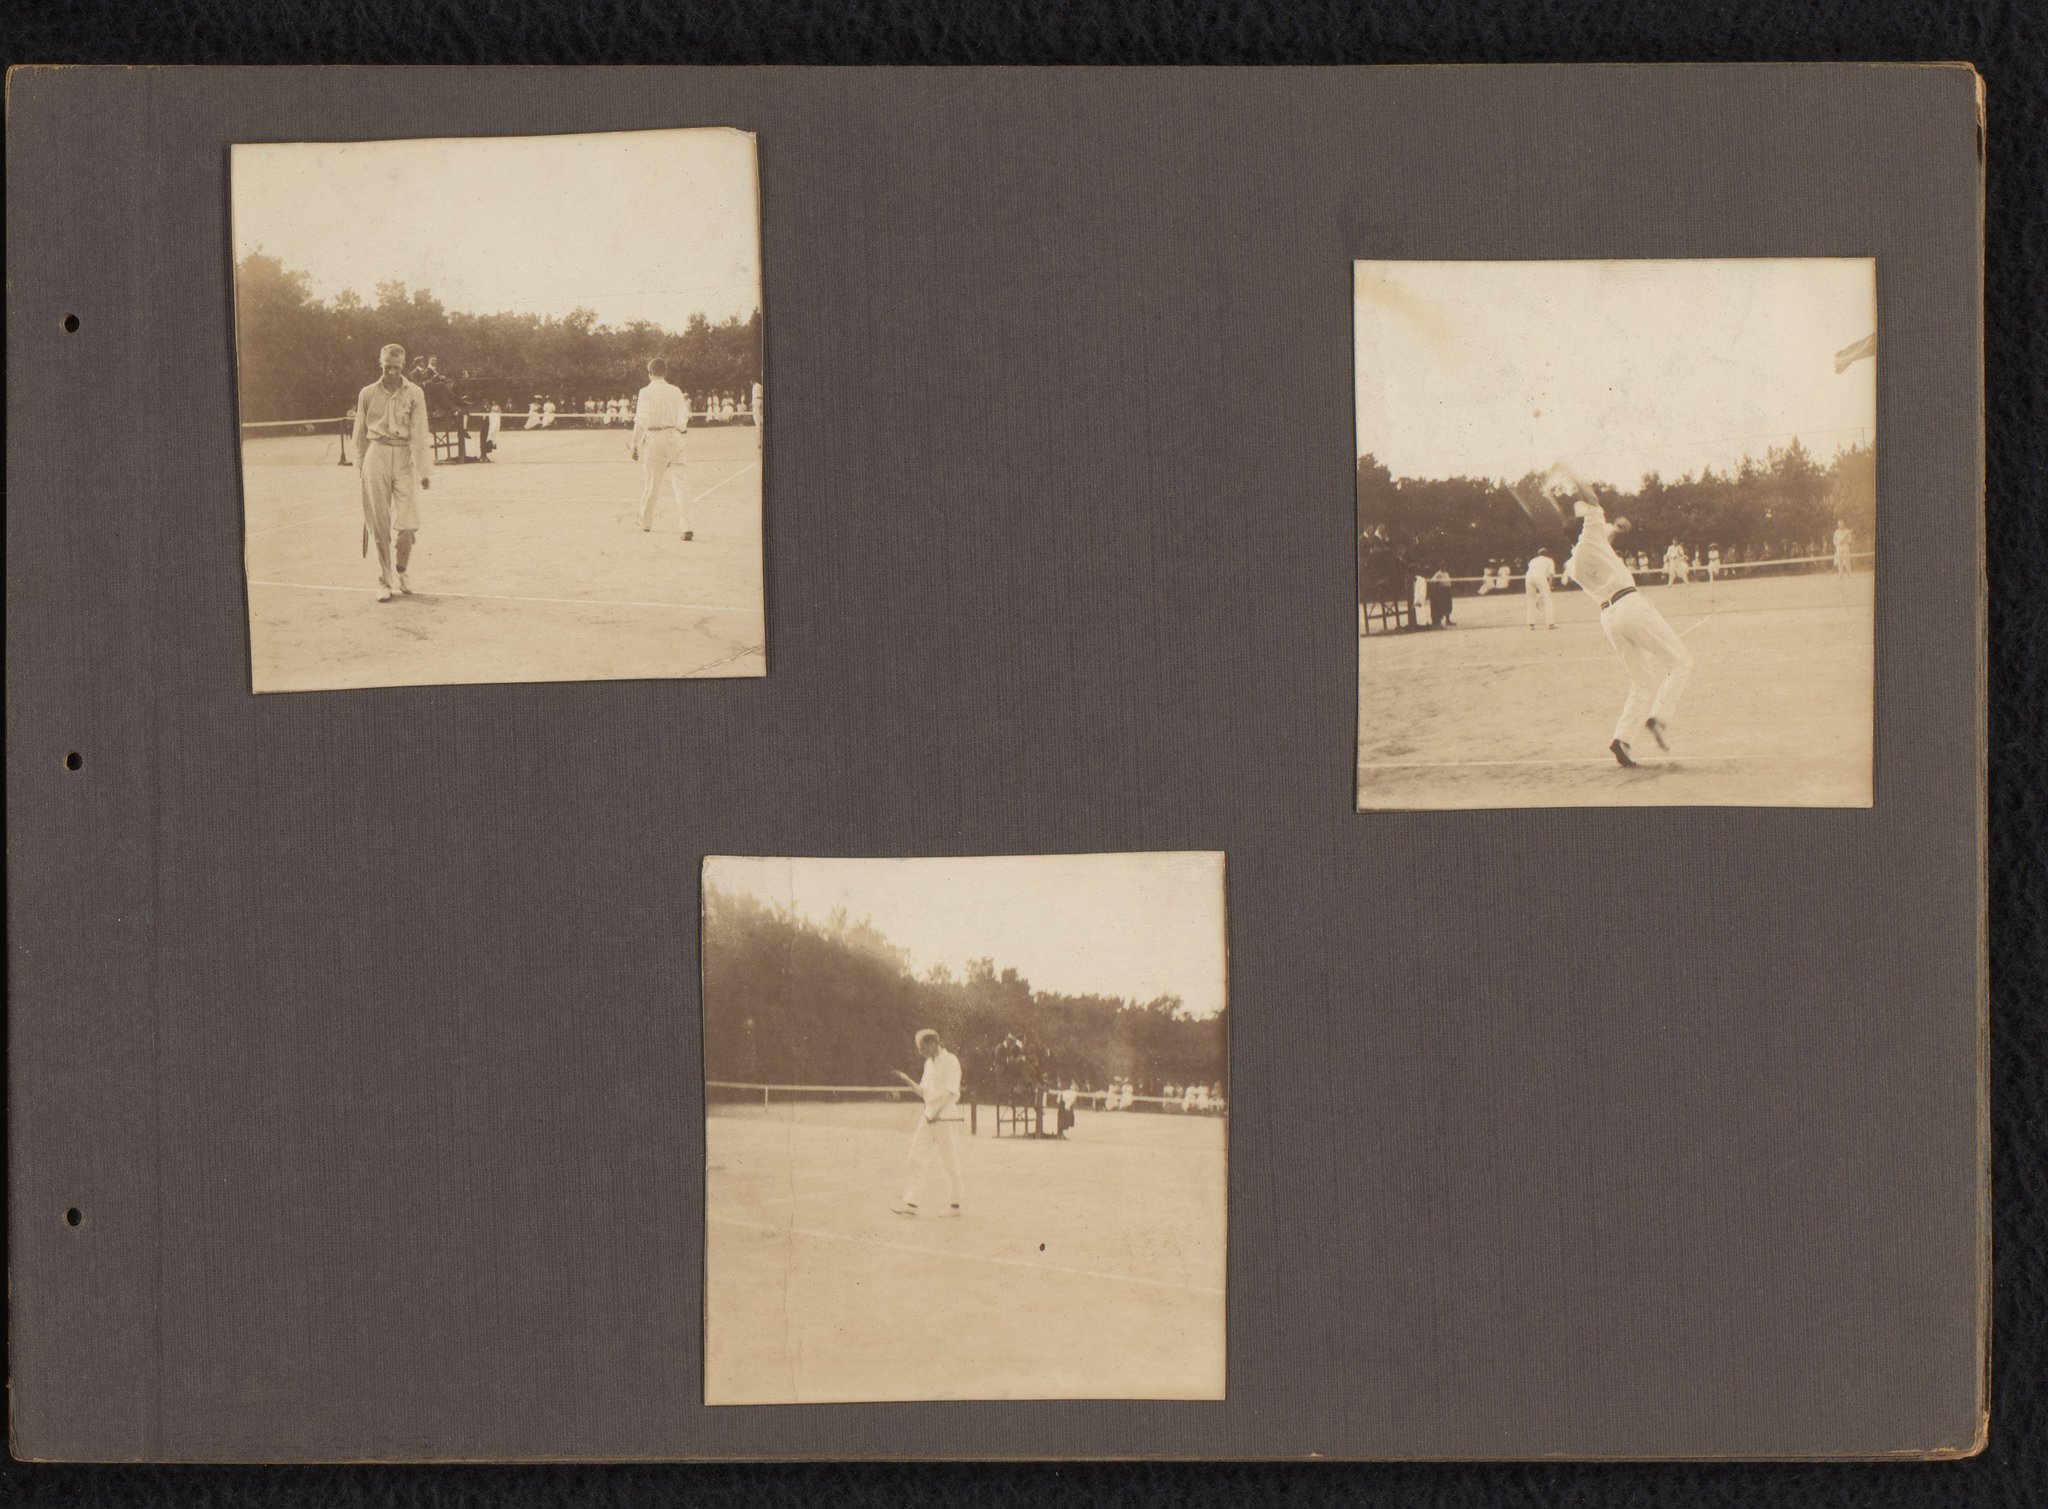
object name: album leaf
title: Tenniswedstrijd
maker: carolina frederika onnen (lien/loen)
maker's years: 1896-1983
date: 1911-1912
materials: paper, cardboard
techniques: gelatin silver print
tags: tennis, lawn-tennis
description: Deze foto's zijn onderdeel van een album.